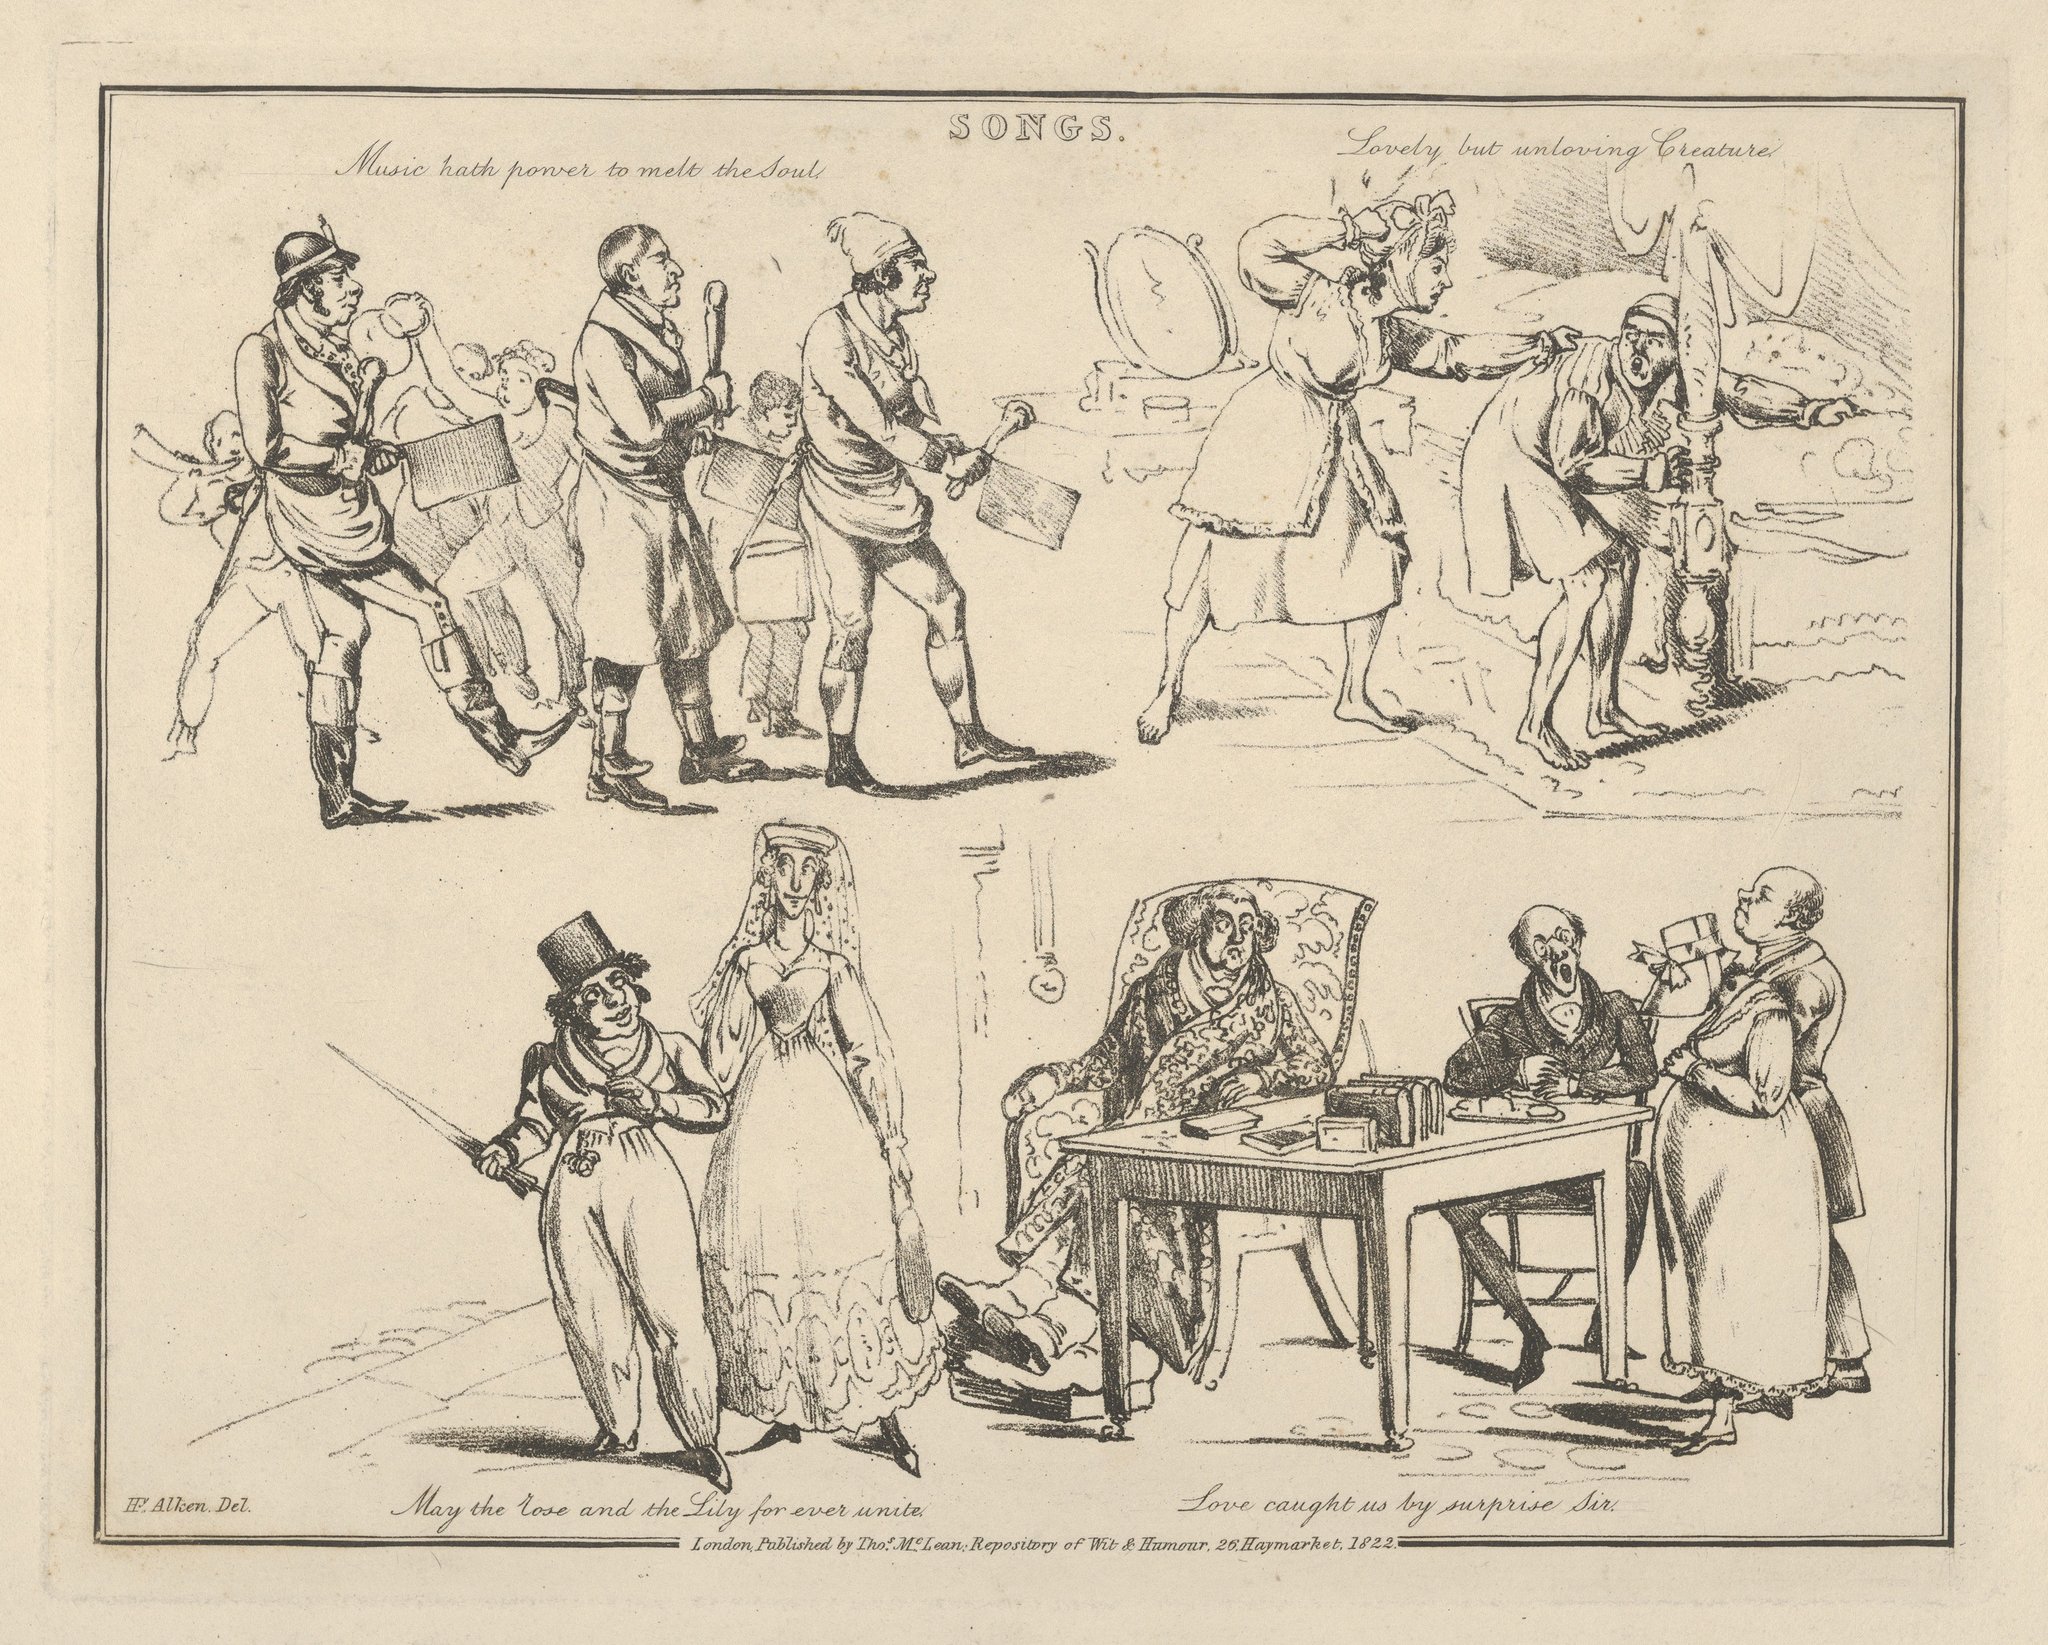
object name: print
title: Songs: "Music hath power to melt the Soul..."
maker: henry alken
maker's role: artist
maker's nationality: british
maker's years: 1785-1851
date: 1822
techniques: etching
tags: men,women,music